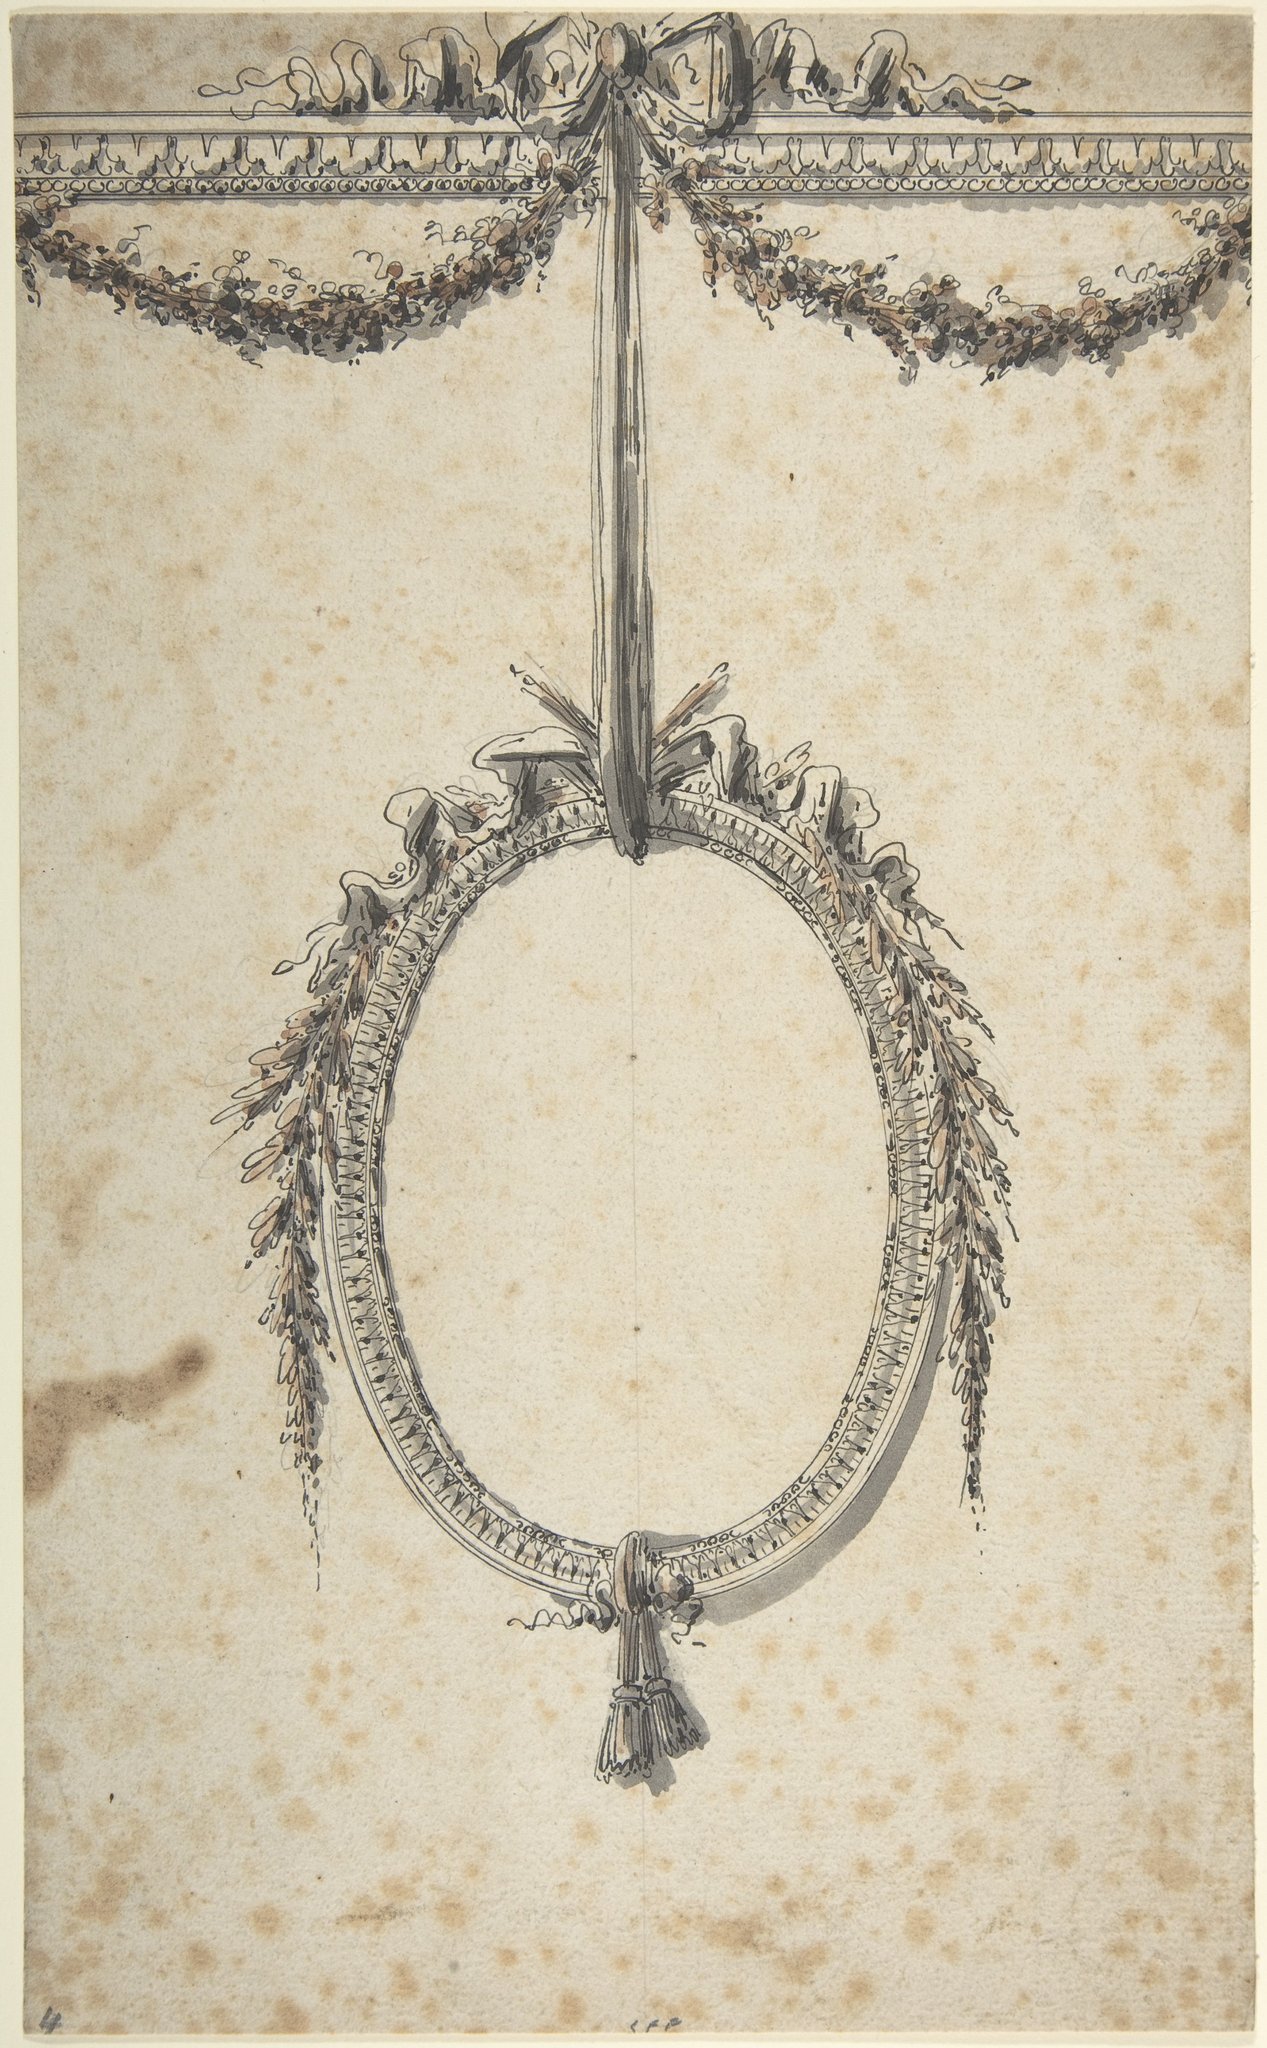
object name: drawing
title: Design for Oval Cartouche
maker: gautier d'agoty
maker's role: artist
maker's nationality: french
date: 1701-1800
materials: graphite, ink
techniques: brush, pen, wash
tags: cartouches,garlands